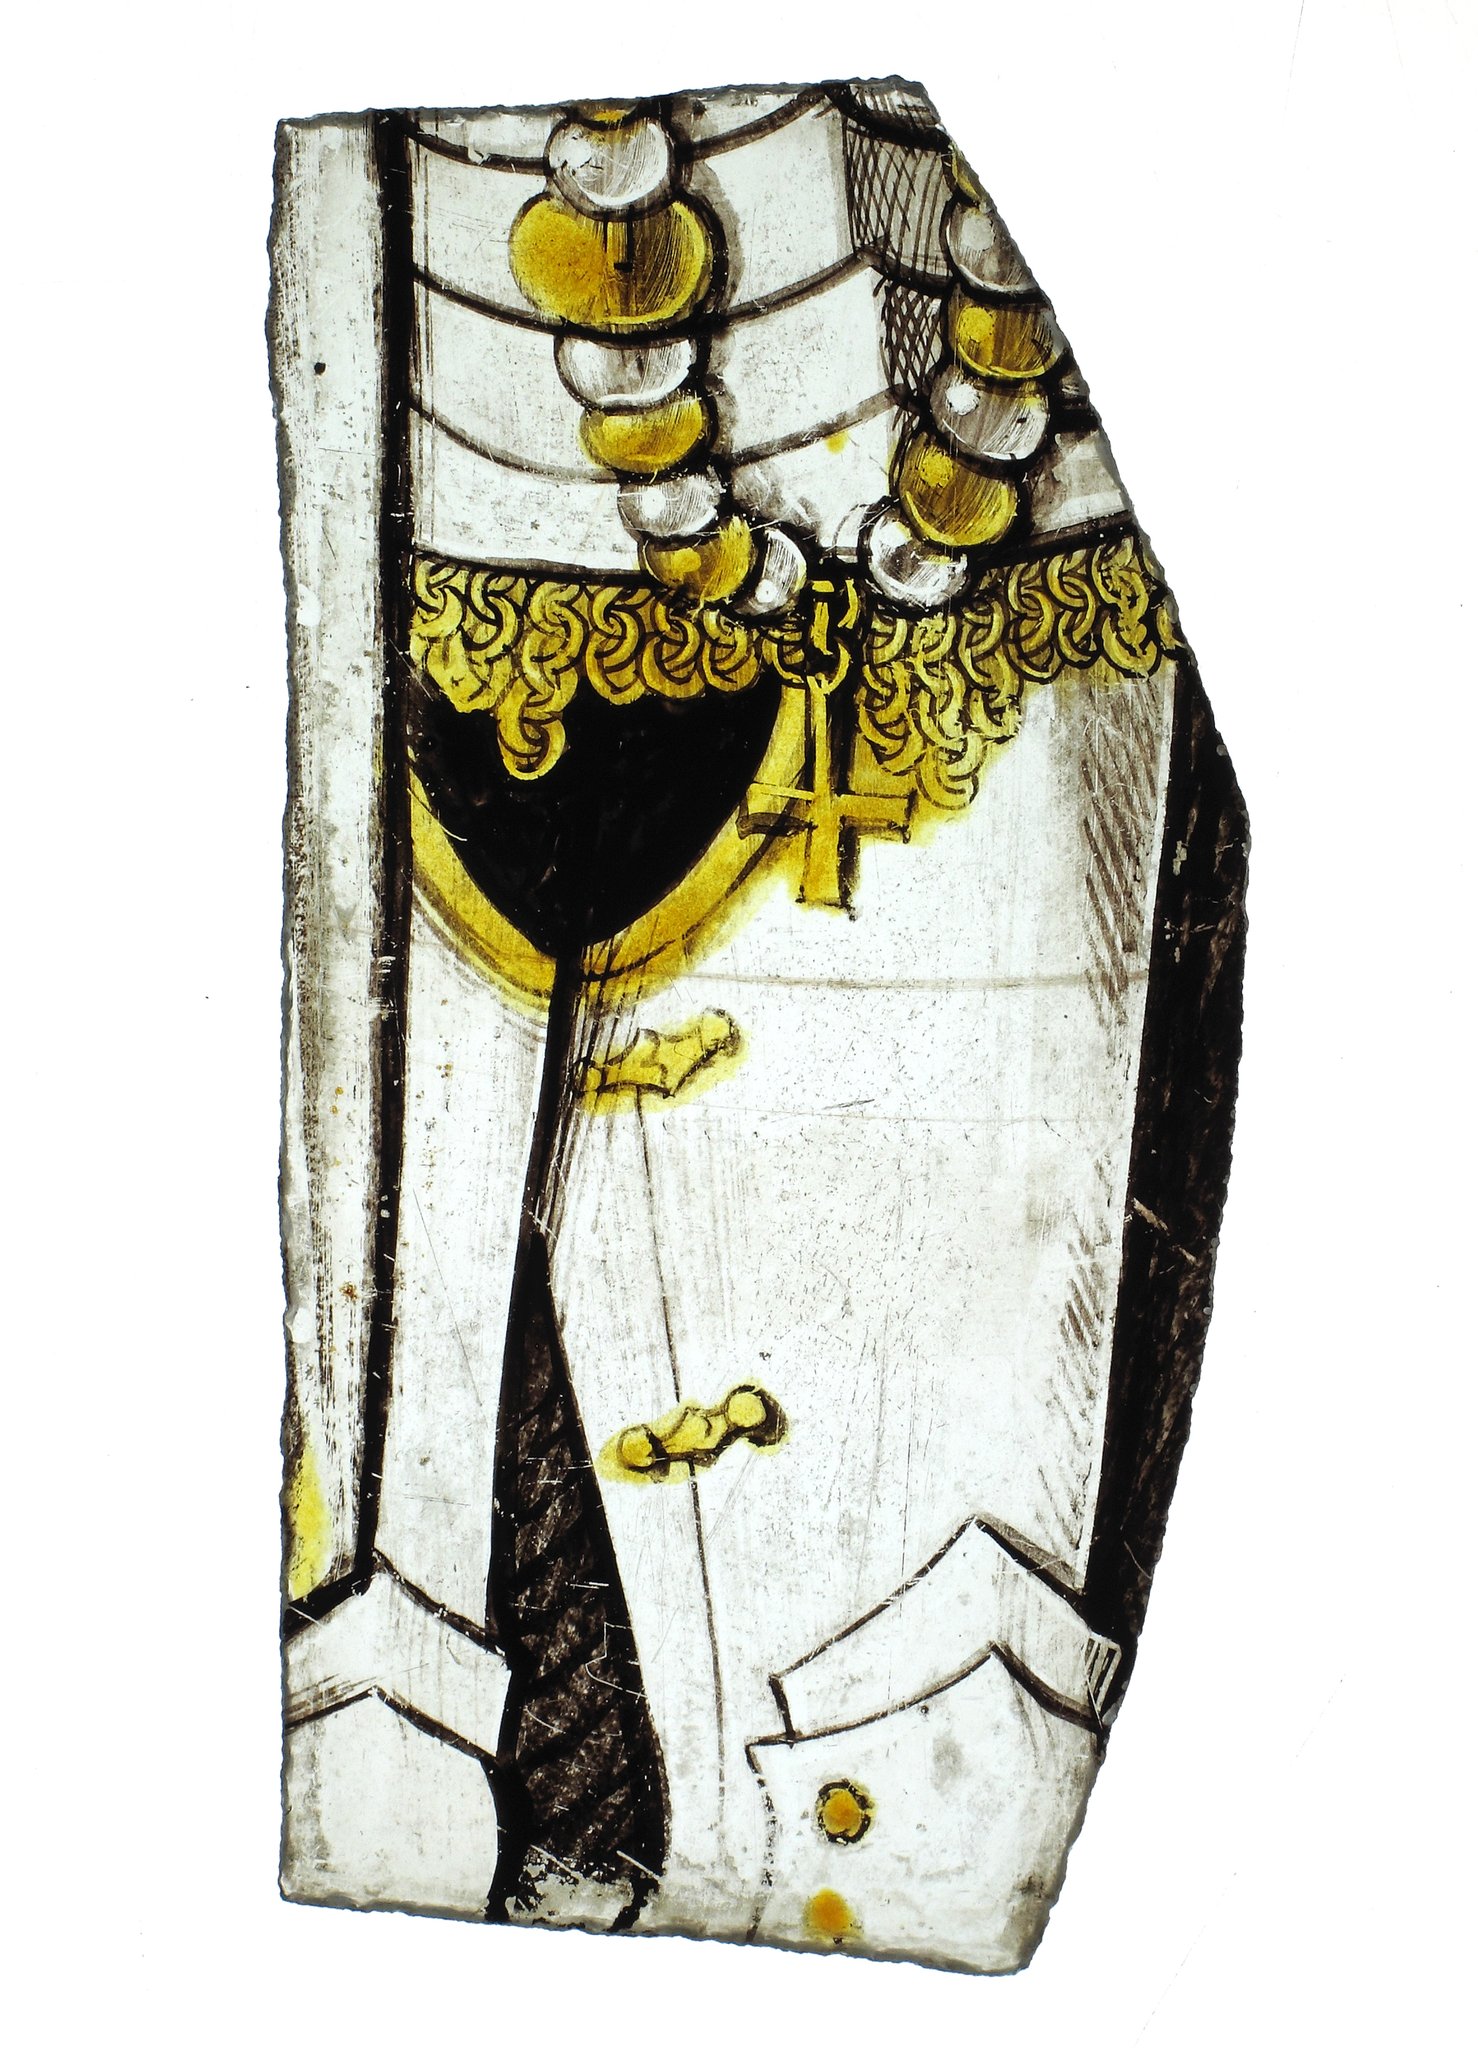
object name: fragment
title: Glass Fragment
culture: south netherlandish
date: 1501-1533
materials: glass, pigment